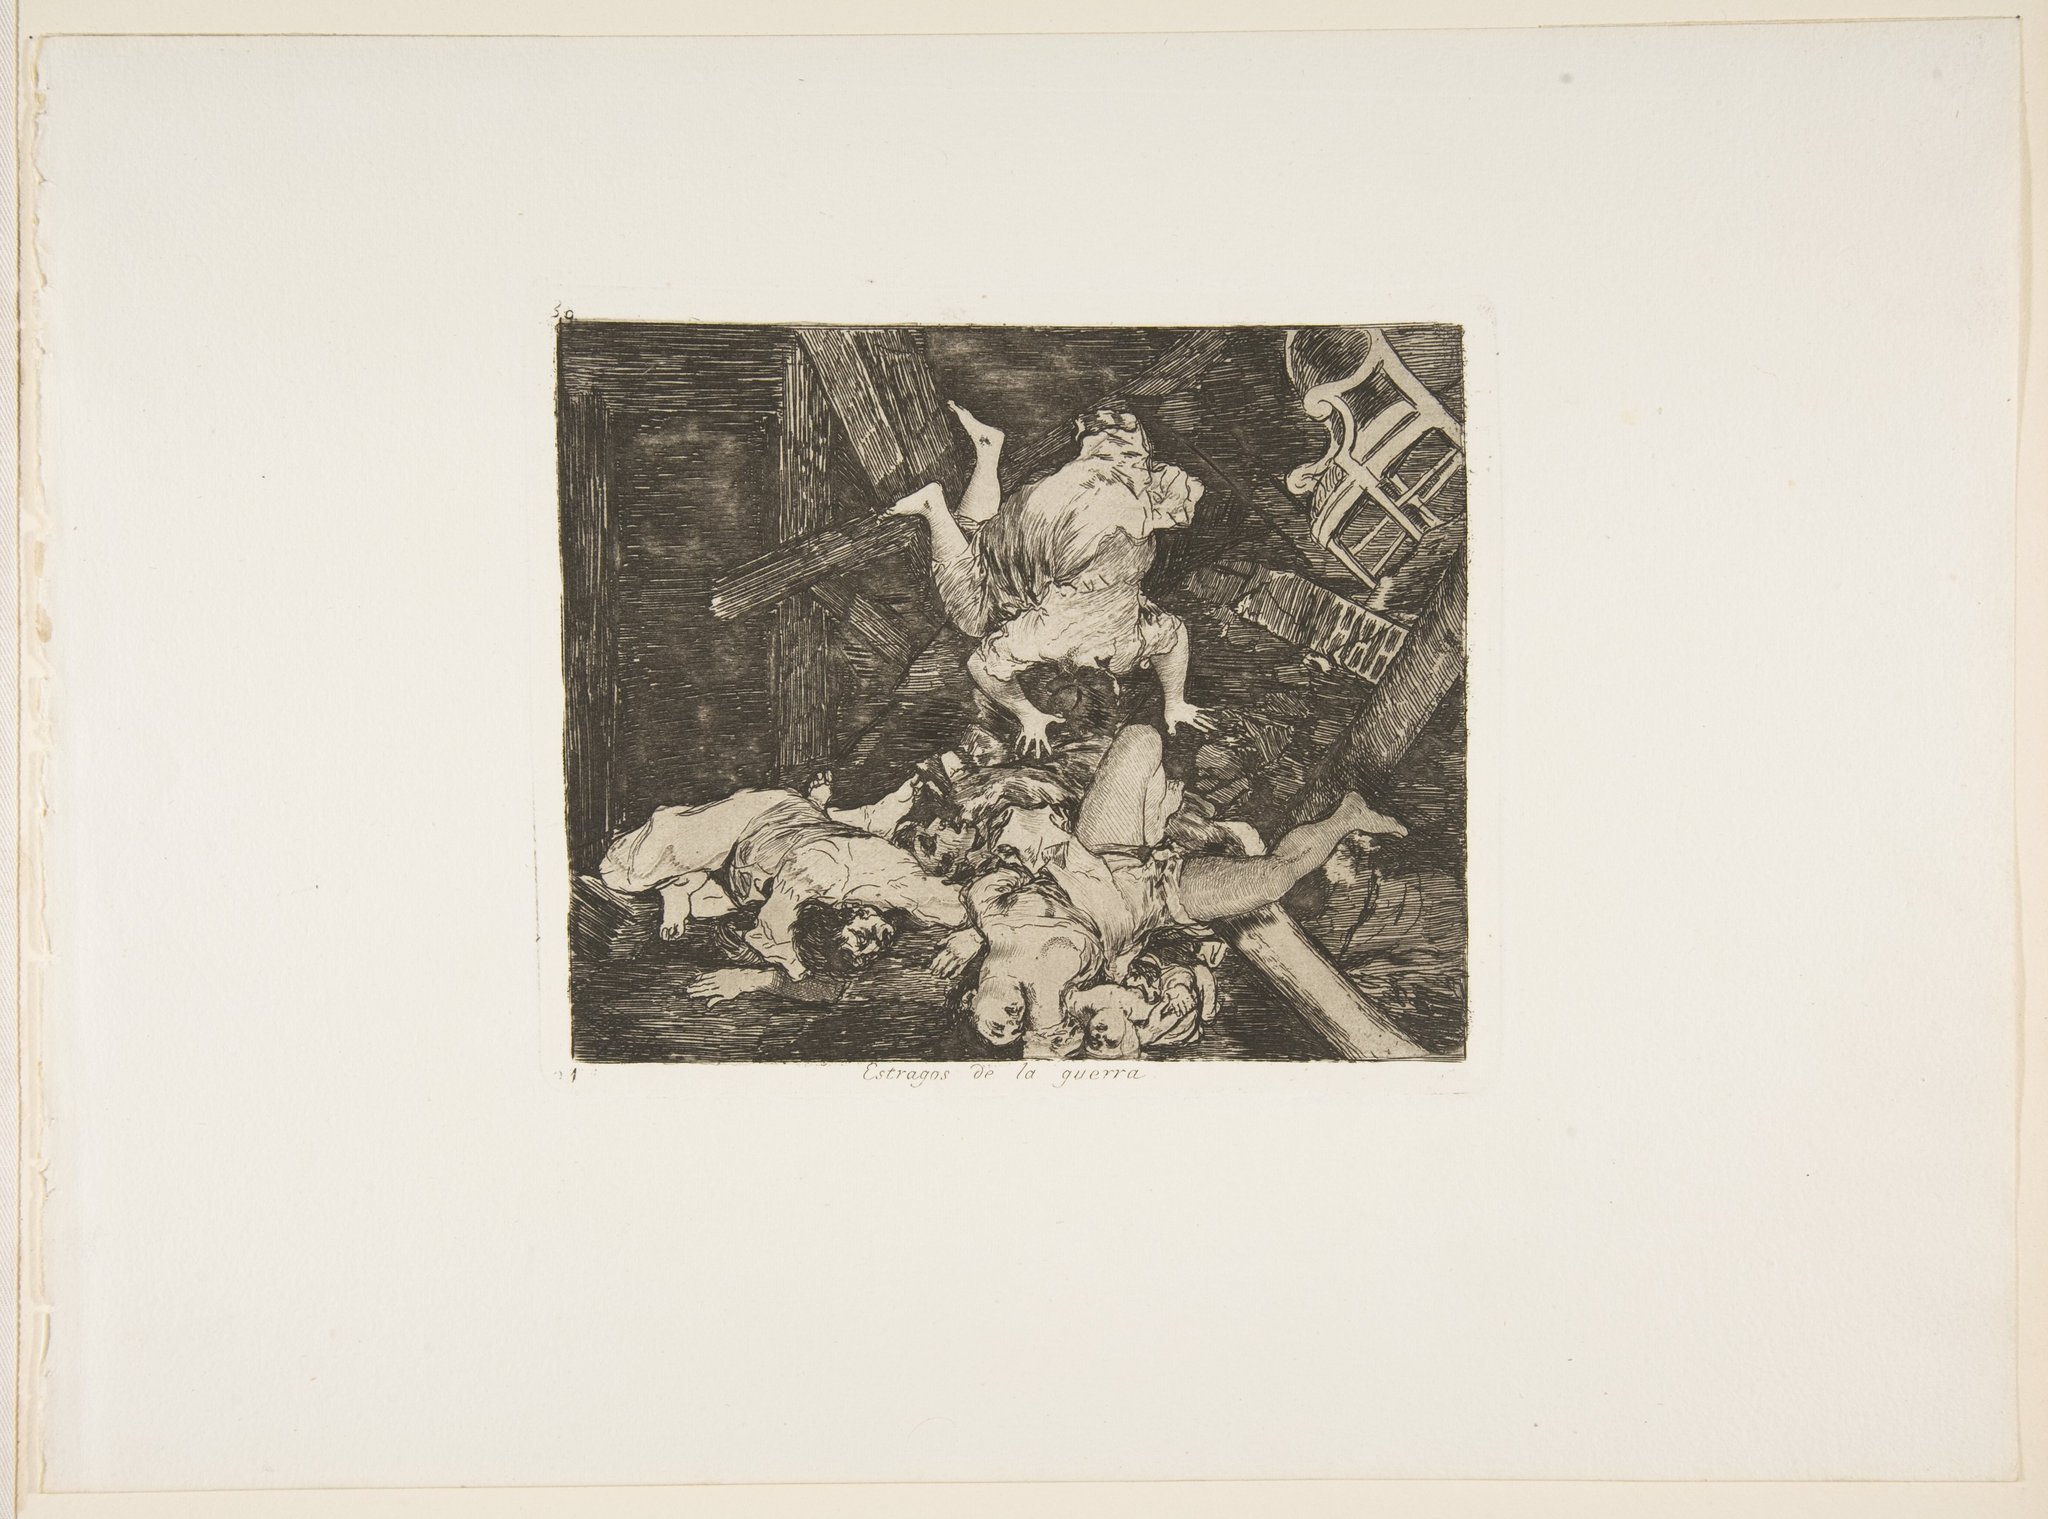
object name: print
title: Plate 30 from "The Disasters of War" (Los Desastres de la Guerra): 'Ravages of war' (Estragos de la guerra)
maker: goya (francisco de goya y lucientes)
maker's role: artist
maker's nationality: spanish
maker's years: 1746-1828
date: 1810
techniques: engraving, drypoint, etching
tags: men,women,death